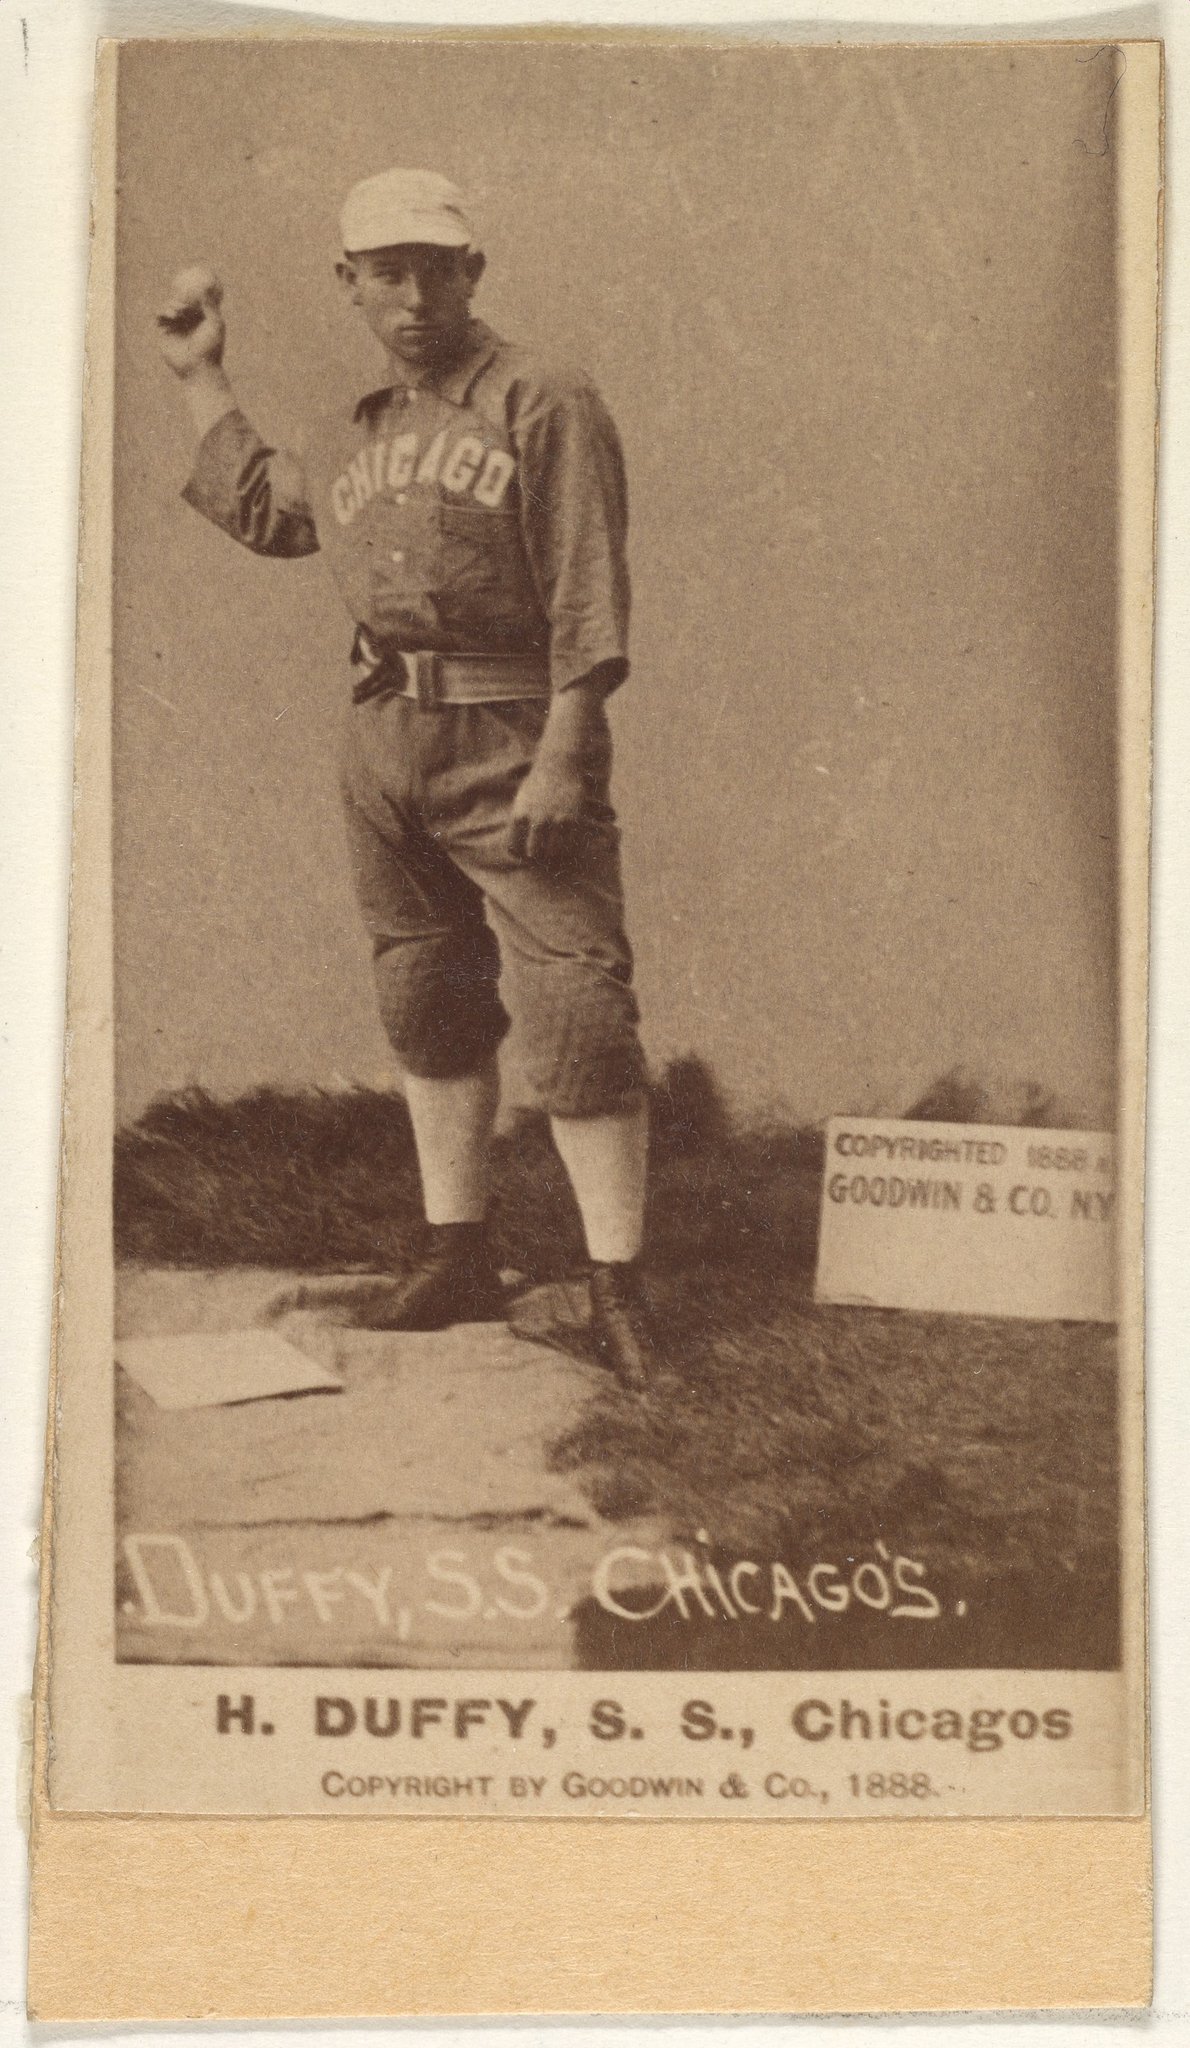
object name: baseball card, photograph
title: Hugh Duffy, Shortstop, Chicago, from the Old Judge series (N172) for Old Judge Cigarettes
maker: goodwin & company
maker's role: publisher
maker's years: 1850-1950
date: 1888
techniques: albumen silver print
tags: men,portraits,baseball,athletes